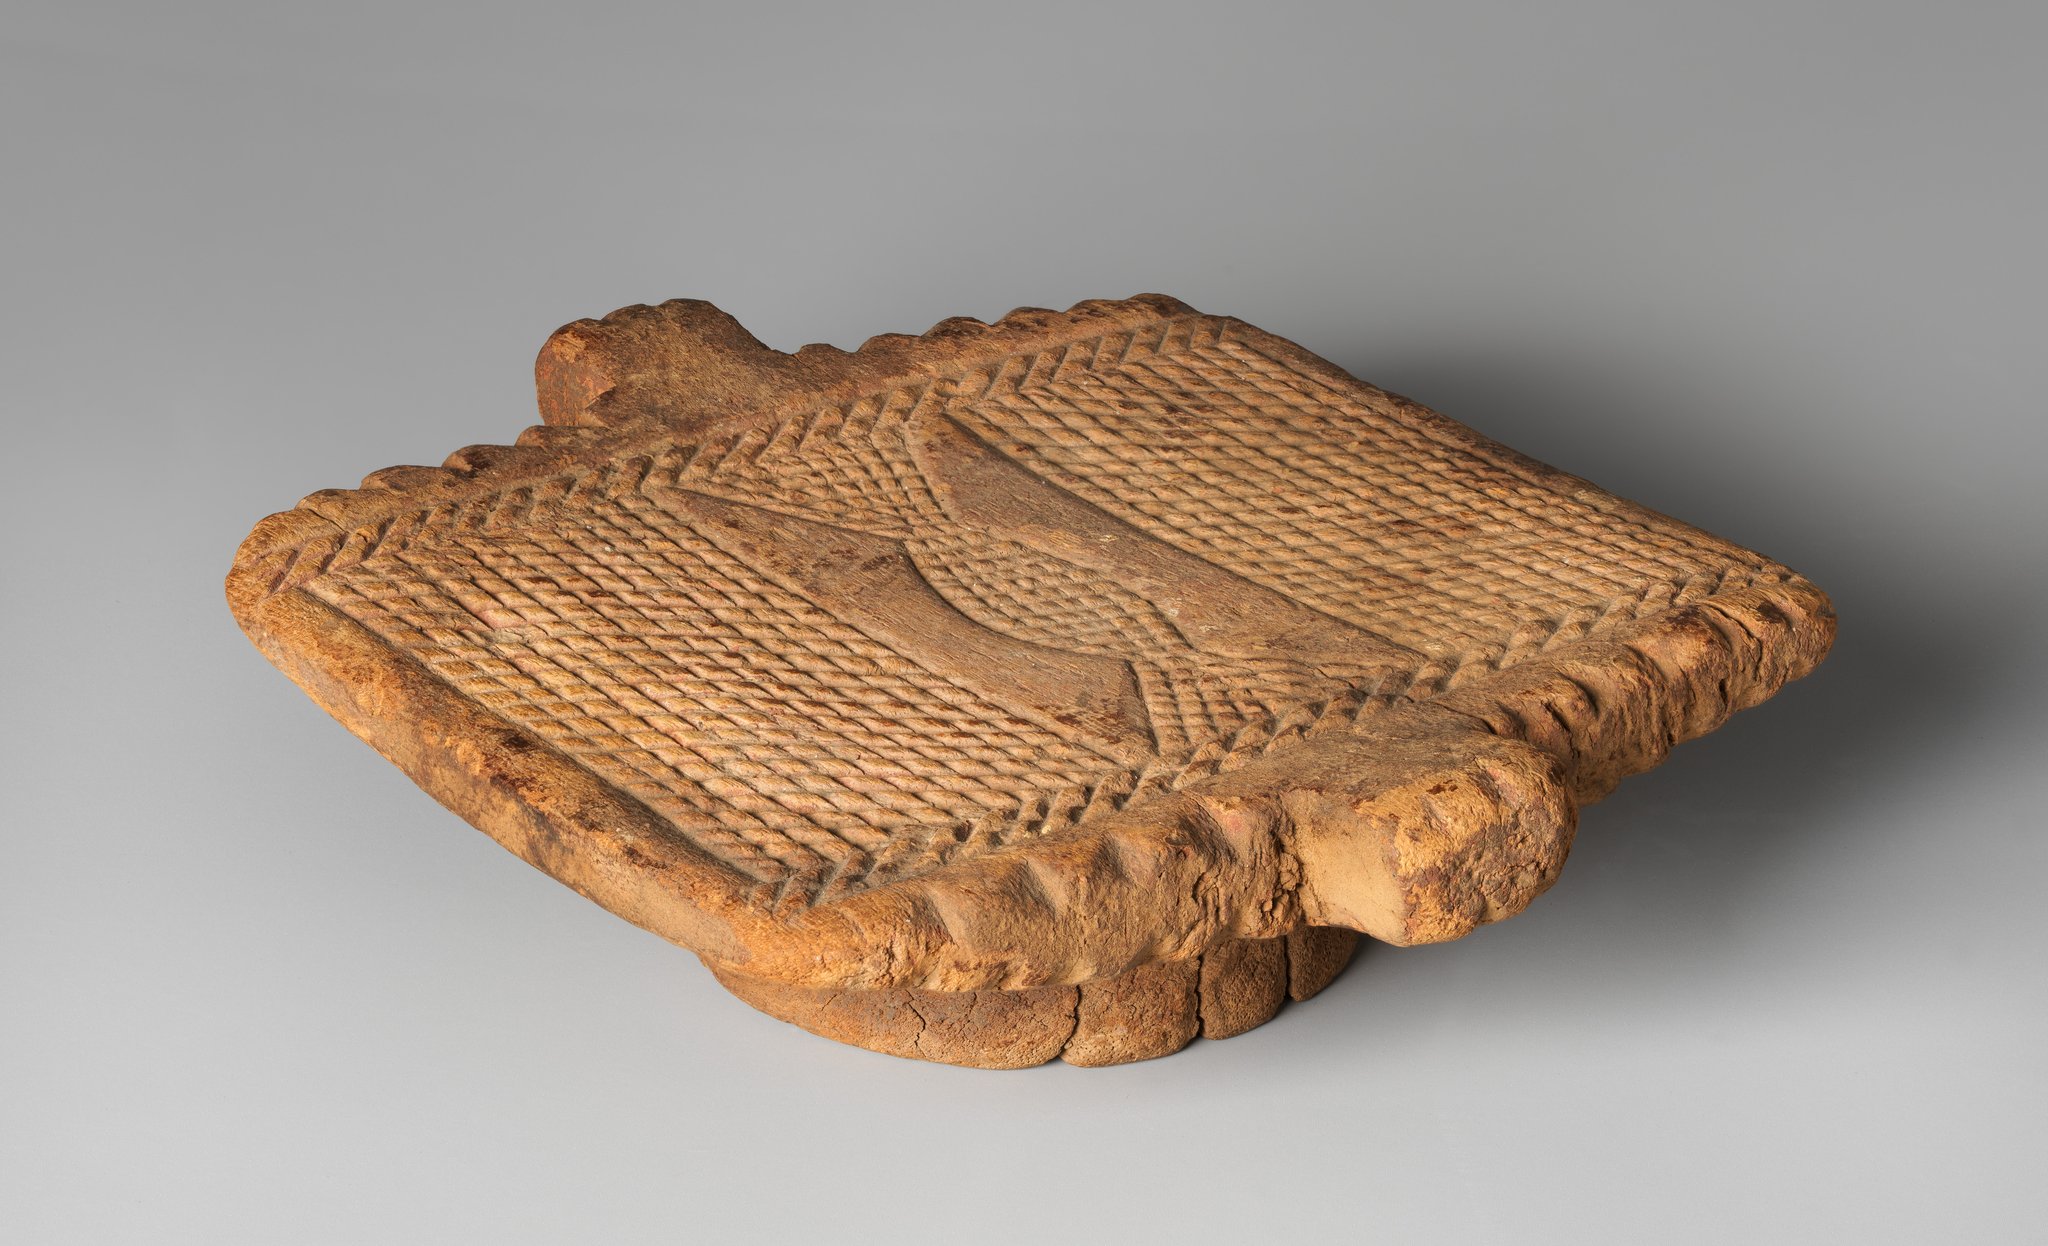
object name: headrest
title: Headrest or headboard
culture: tellem peoples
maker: tellem artist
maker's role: artist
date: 1501-1600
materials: wood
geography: mali